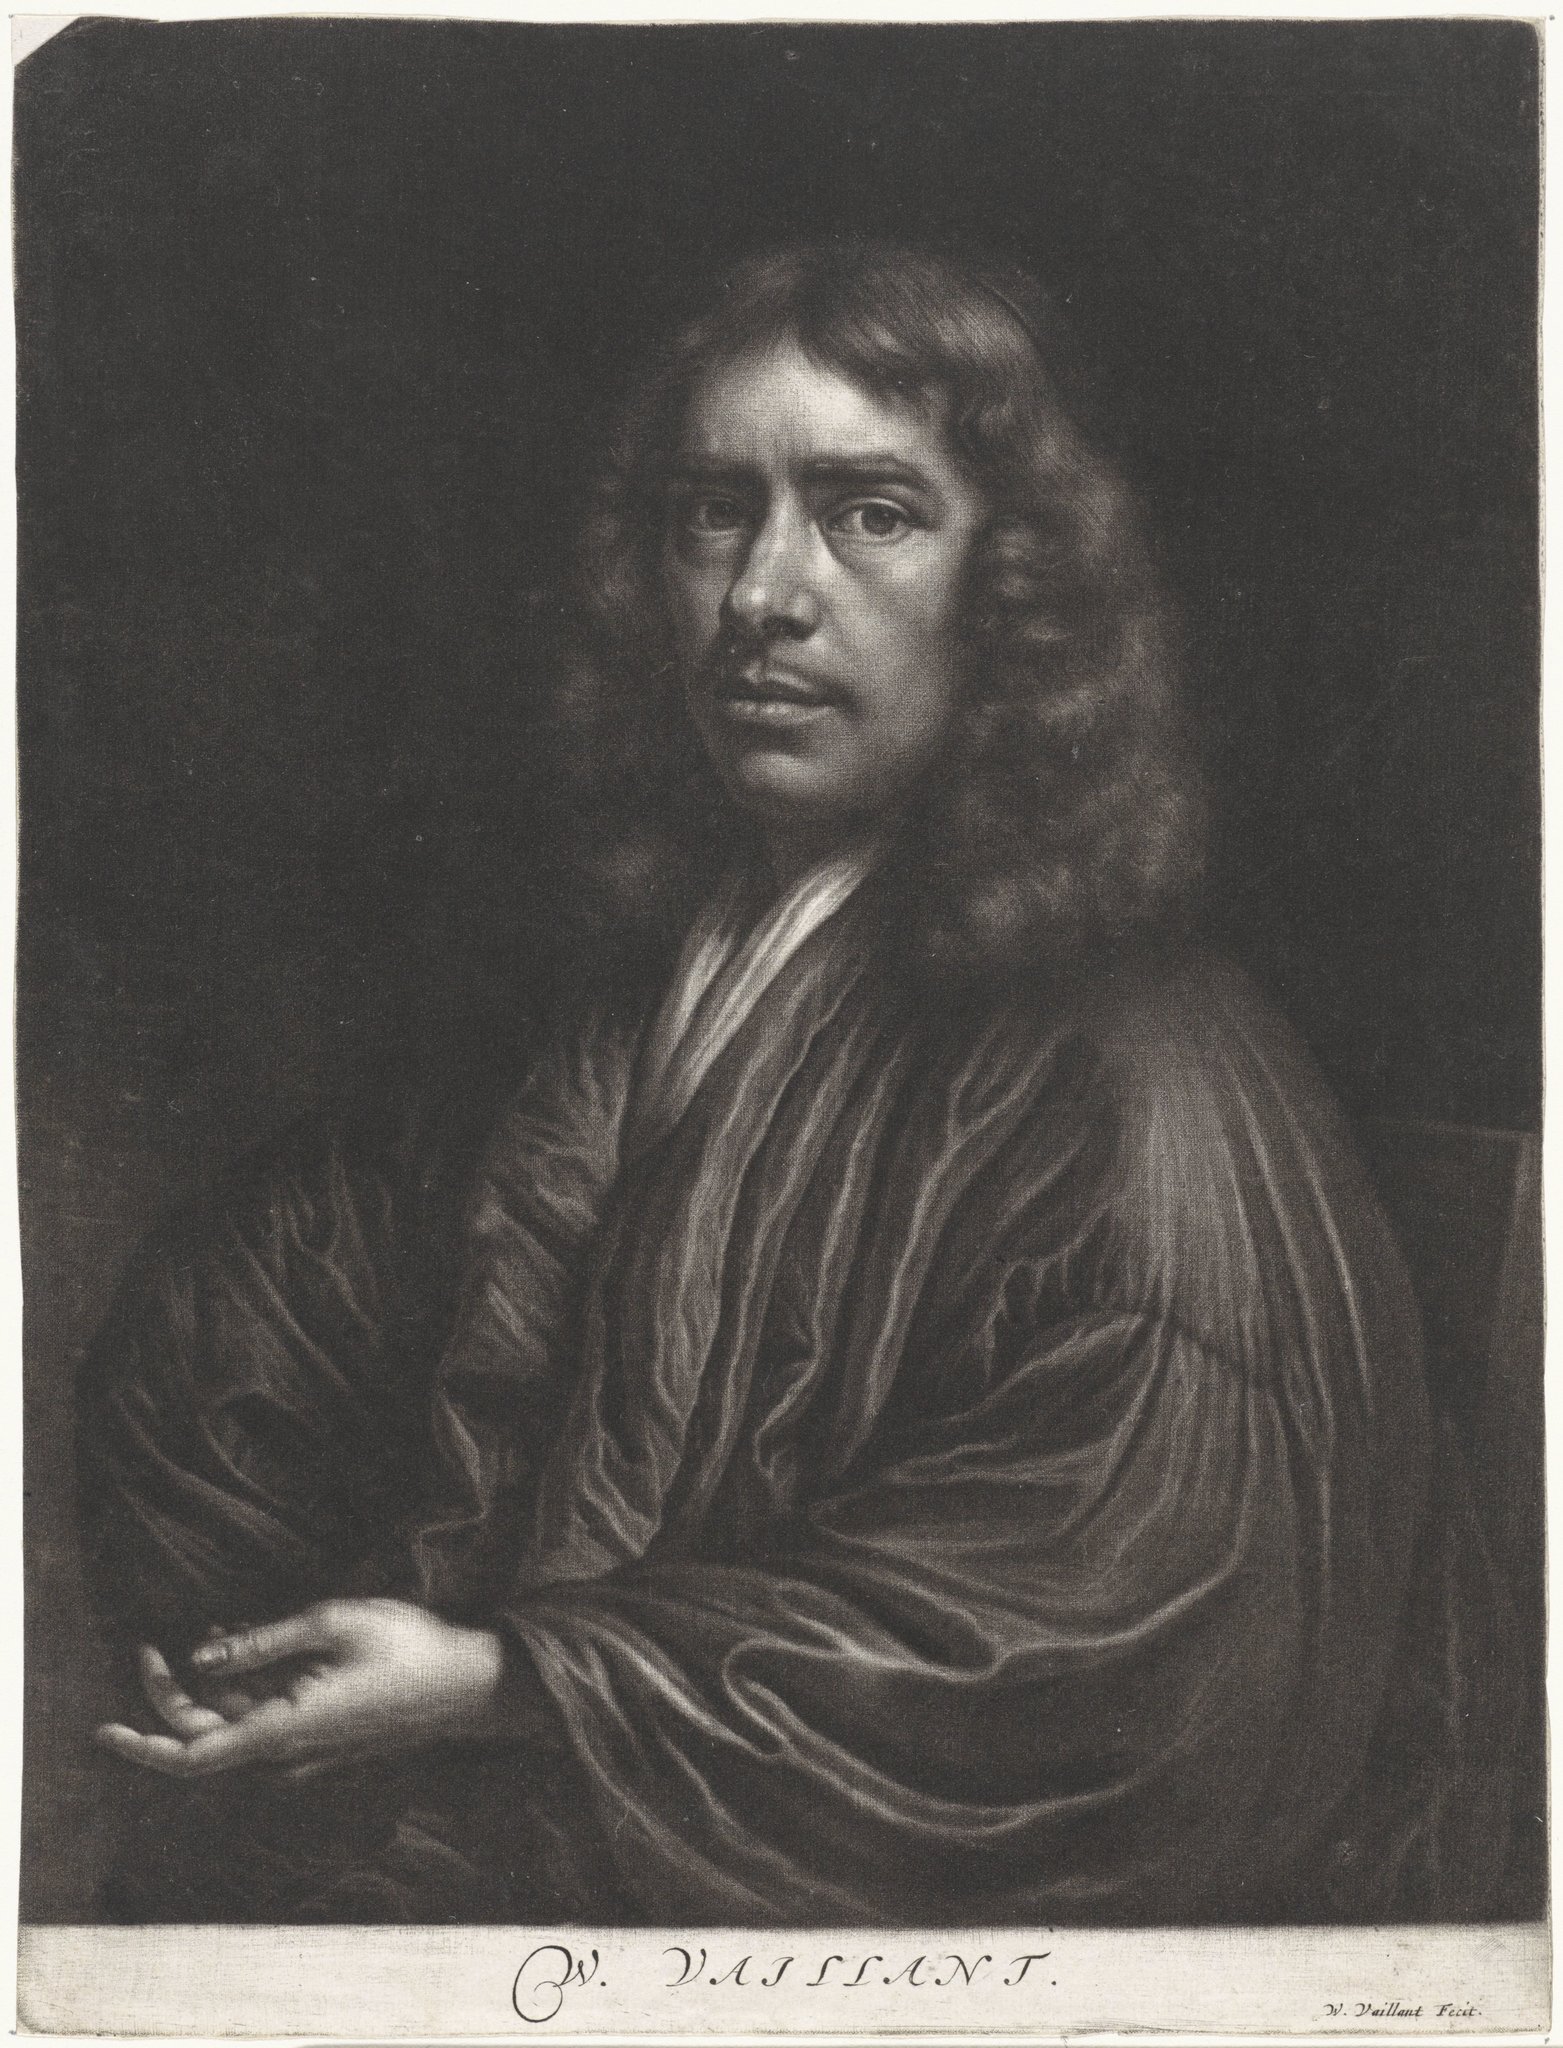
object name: print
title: Zelfportret van Wallerant Vaillant met een kapje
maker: wallerant vaillant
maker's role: draughtsman, painter, print maker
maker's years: 1623-1677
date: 1658-1677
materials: paper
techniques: mezzotint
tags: amsterdam, painter, print maker, wallerant vaillant, portrait, self-portrait of painter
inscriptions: collector's mark: Lugt 760